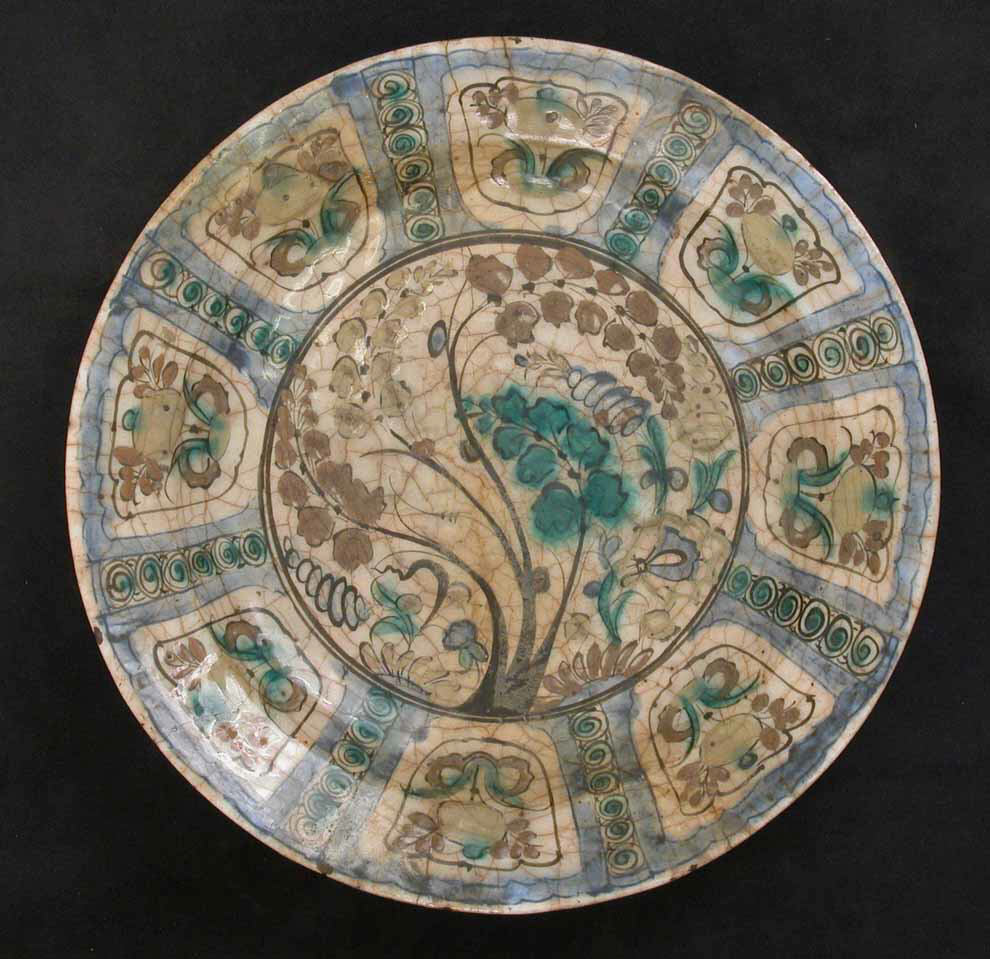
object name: dish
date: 1601-1700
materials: stonepaste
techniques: painting, underglaze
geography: iran